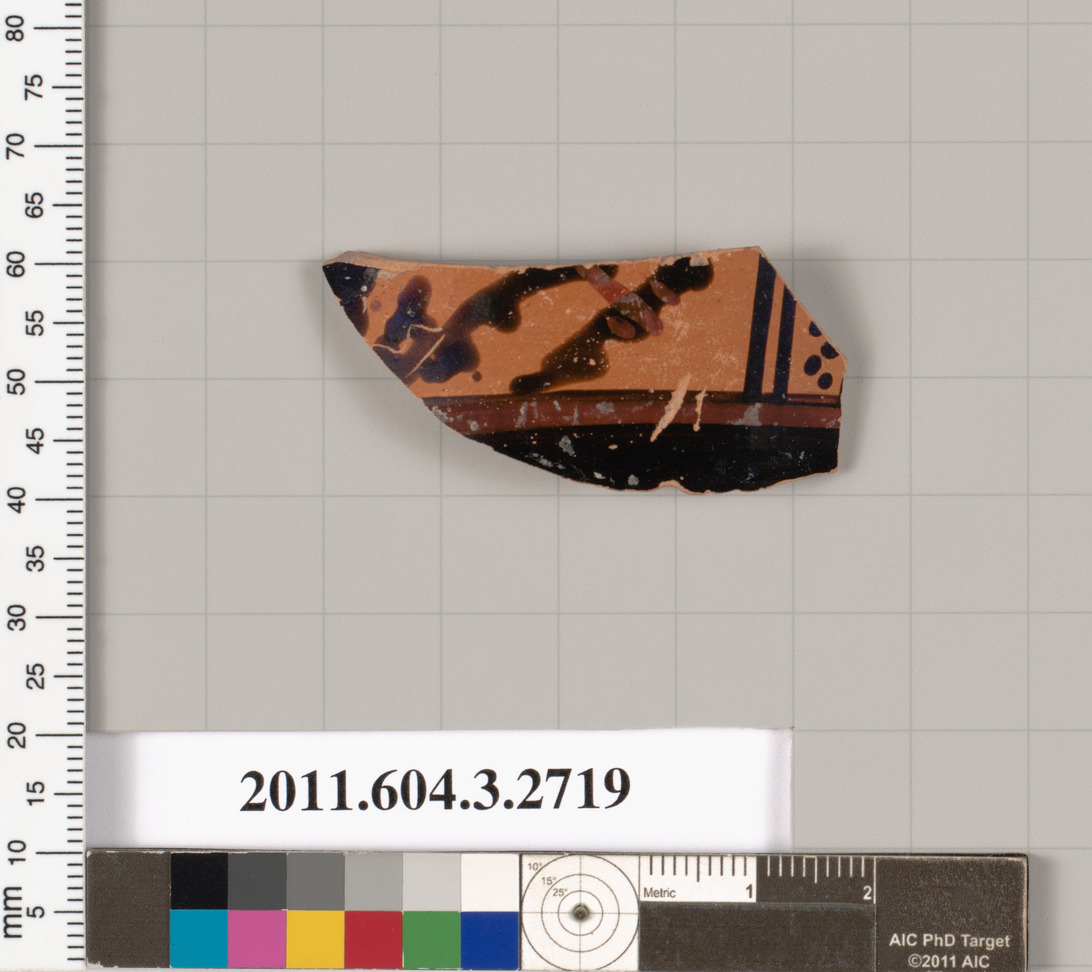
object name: oinochoe or olpe fragment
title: Terracotta fragment of an oinochoe (jug) or olpe (jug)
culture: greek, attic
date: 534-468 BCE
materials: terracotta